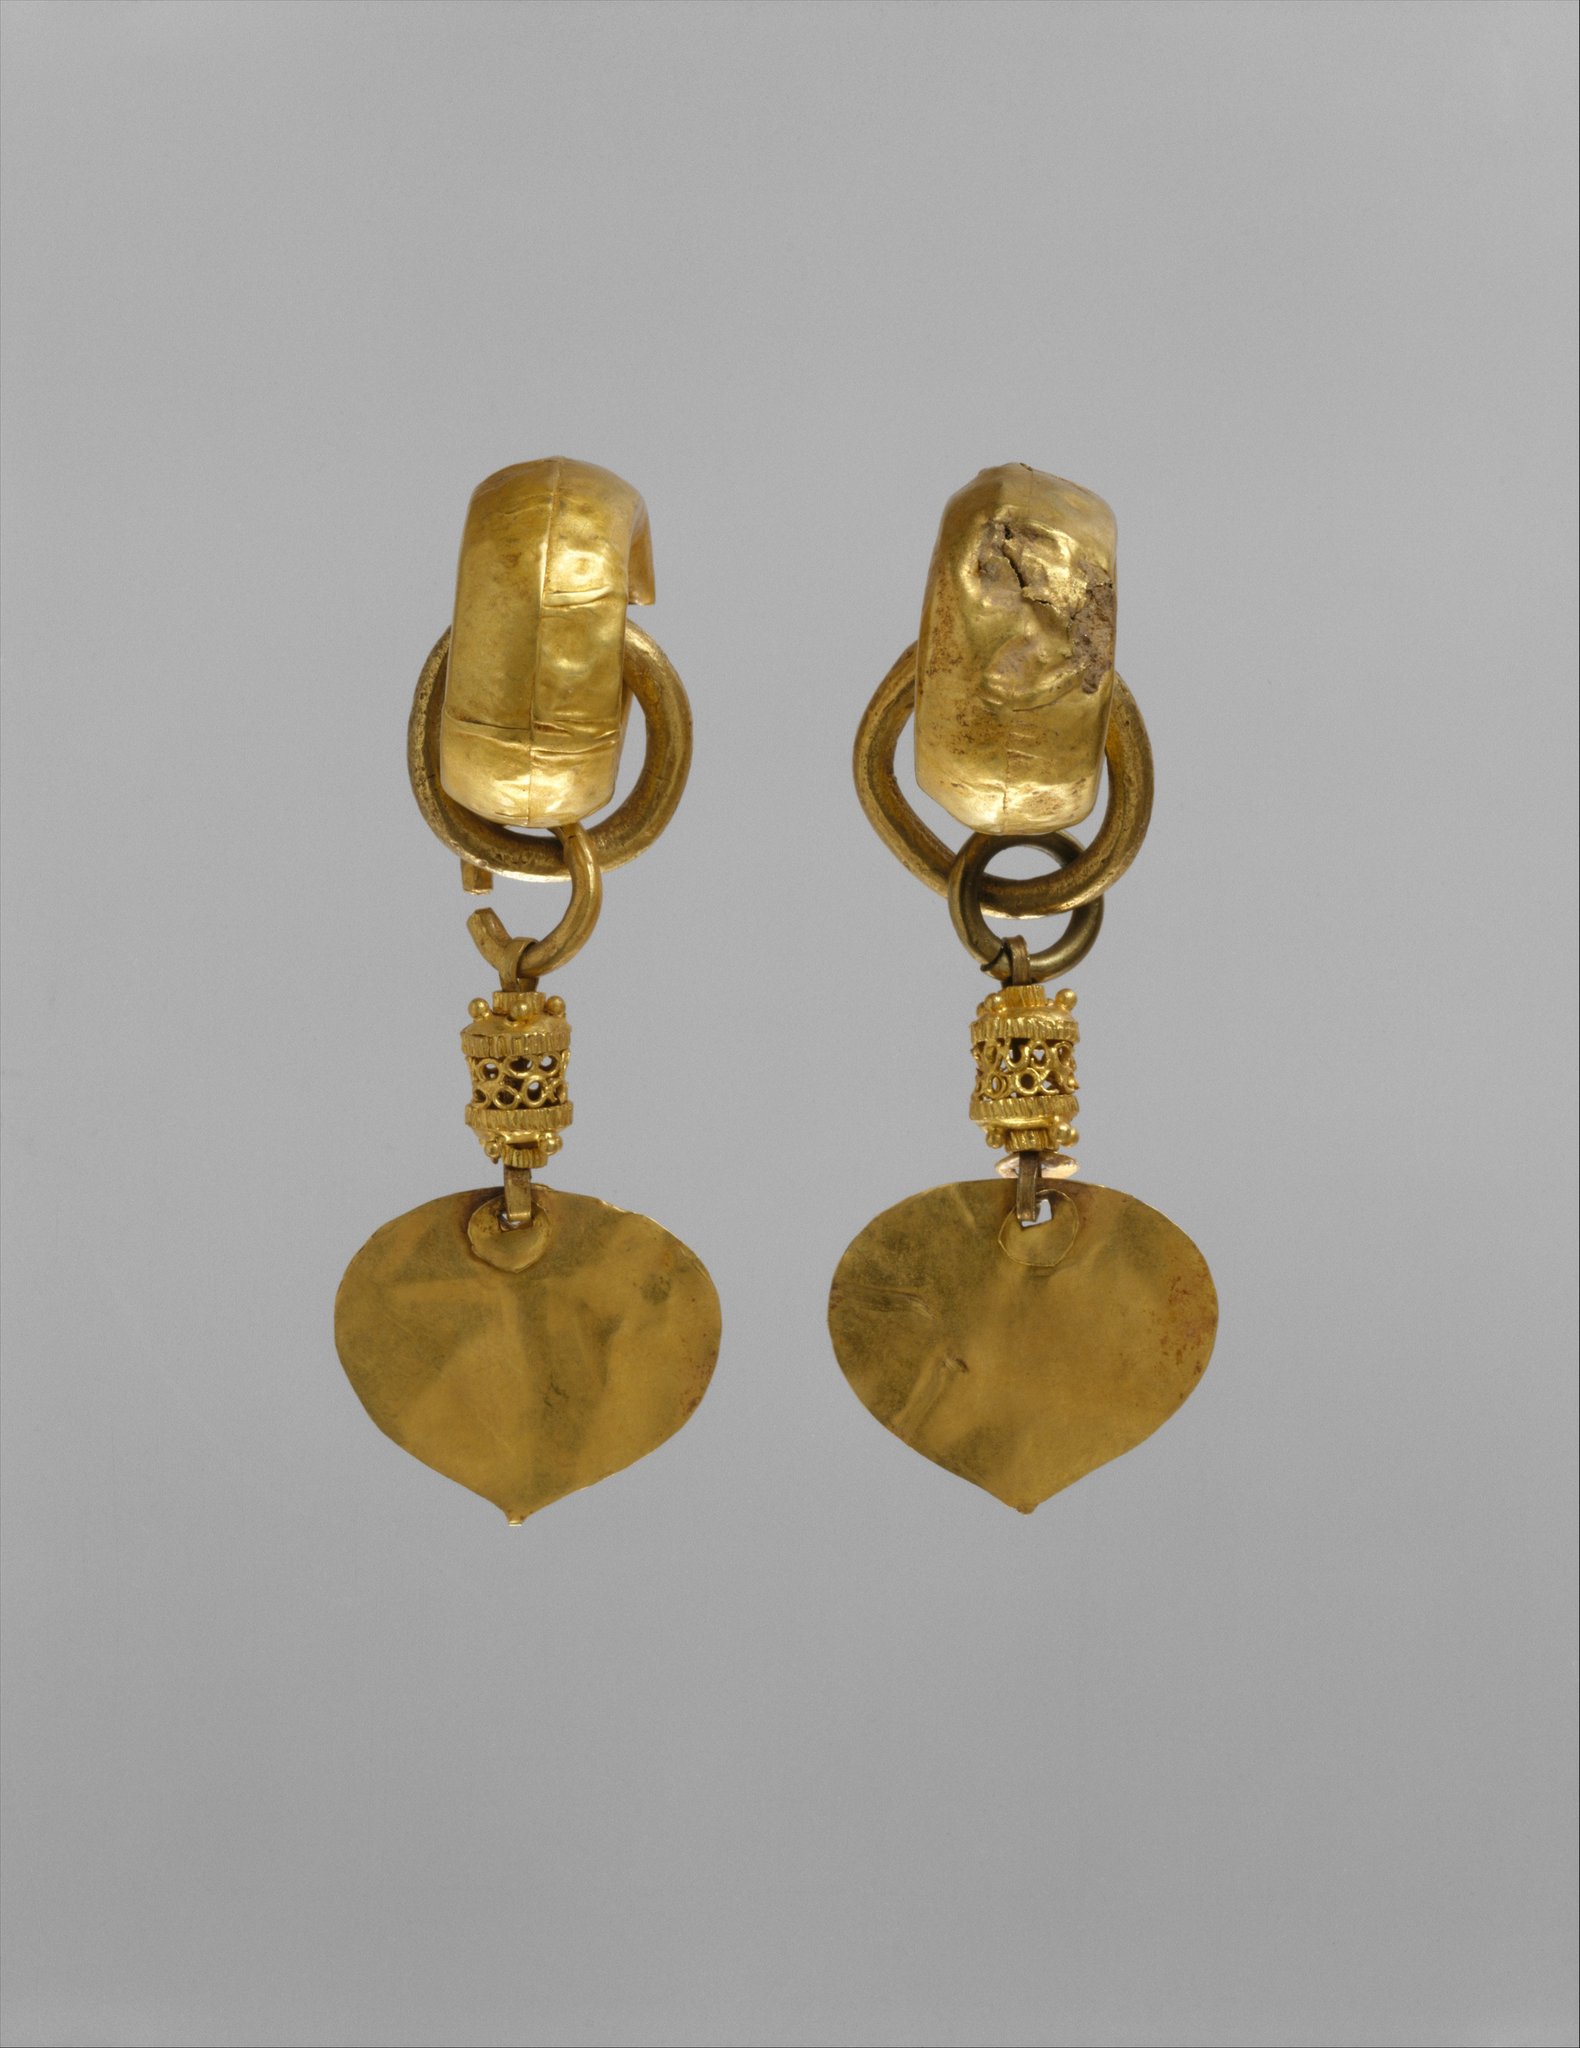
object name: earring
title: Earring (one of a pair)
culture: korean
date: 401-500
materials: gold